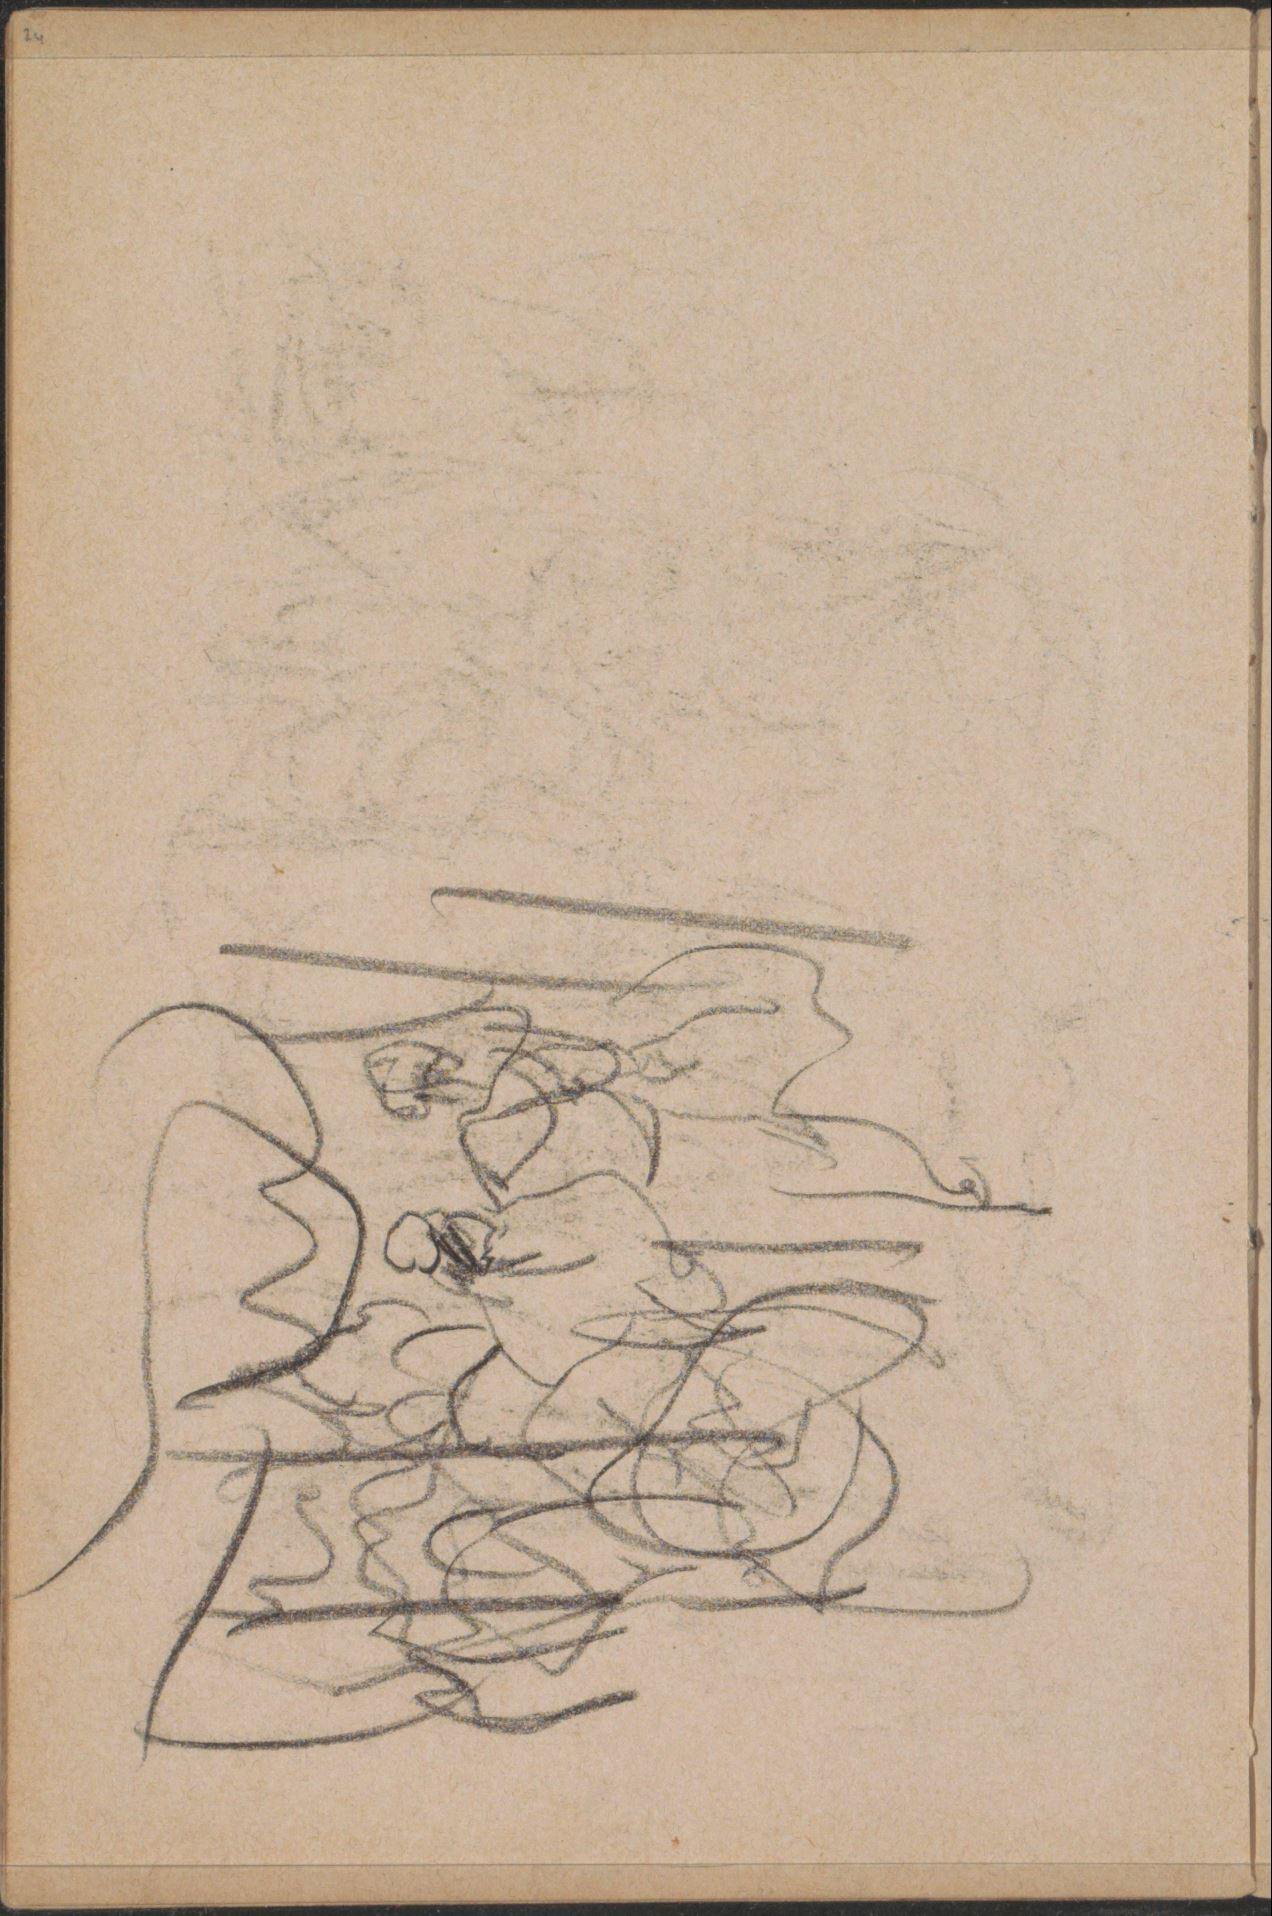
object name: sketchbook leaf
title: Figuren onder een baldakijn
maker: marius bauer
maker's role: draughtsman, print maker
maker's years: 1867-1932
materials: chalk, paper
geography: moscow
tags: coronation procession, standing figure, canopy, baldachin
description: De baldakijn of troonhemel werd meegedragen in de processie voor tsaar Nicolaas II. Pagina 24 uit een schetsboek met 54 bladen.